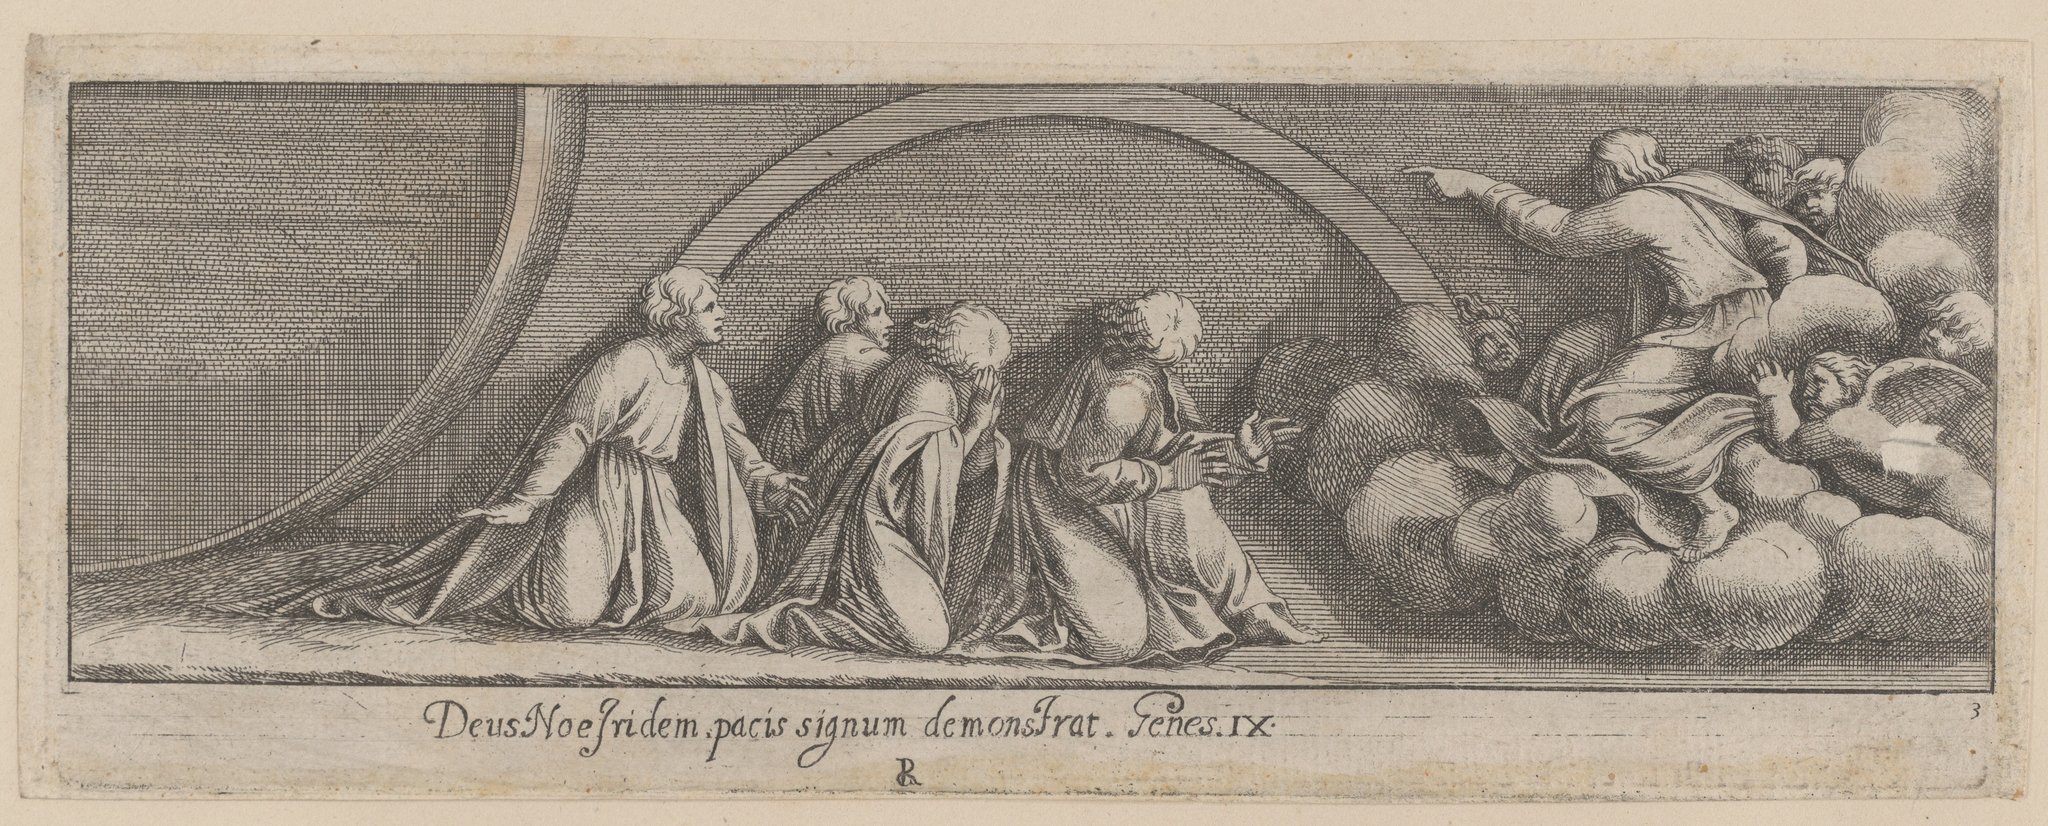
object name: print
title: Plate 3: God Addressing Noah and his Sons, from Genesis Chapter 3, after a lost fresco in the basamento of Bay 13 of the Vatican Loggia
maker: pietro santi bartoli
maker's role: artist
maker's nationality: italian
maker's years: 1615-1700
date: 1650-1677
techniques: etching